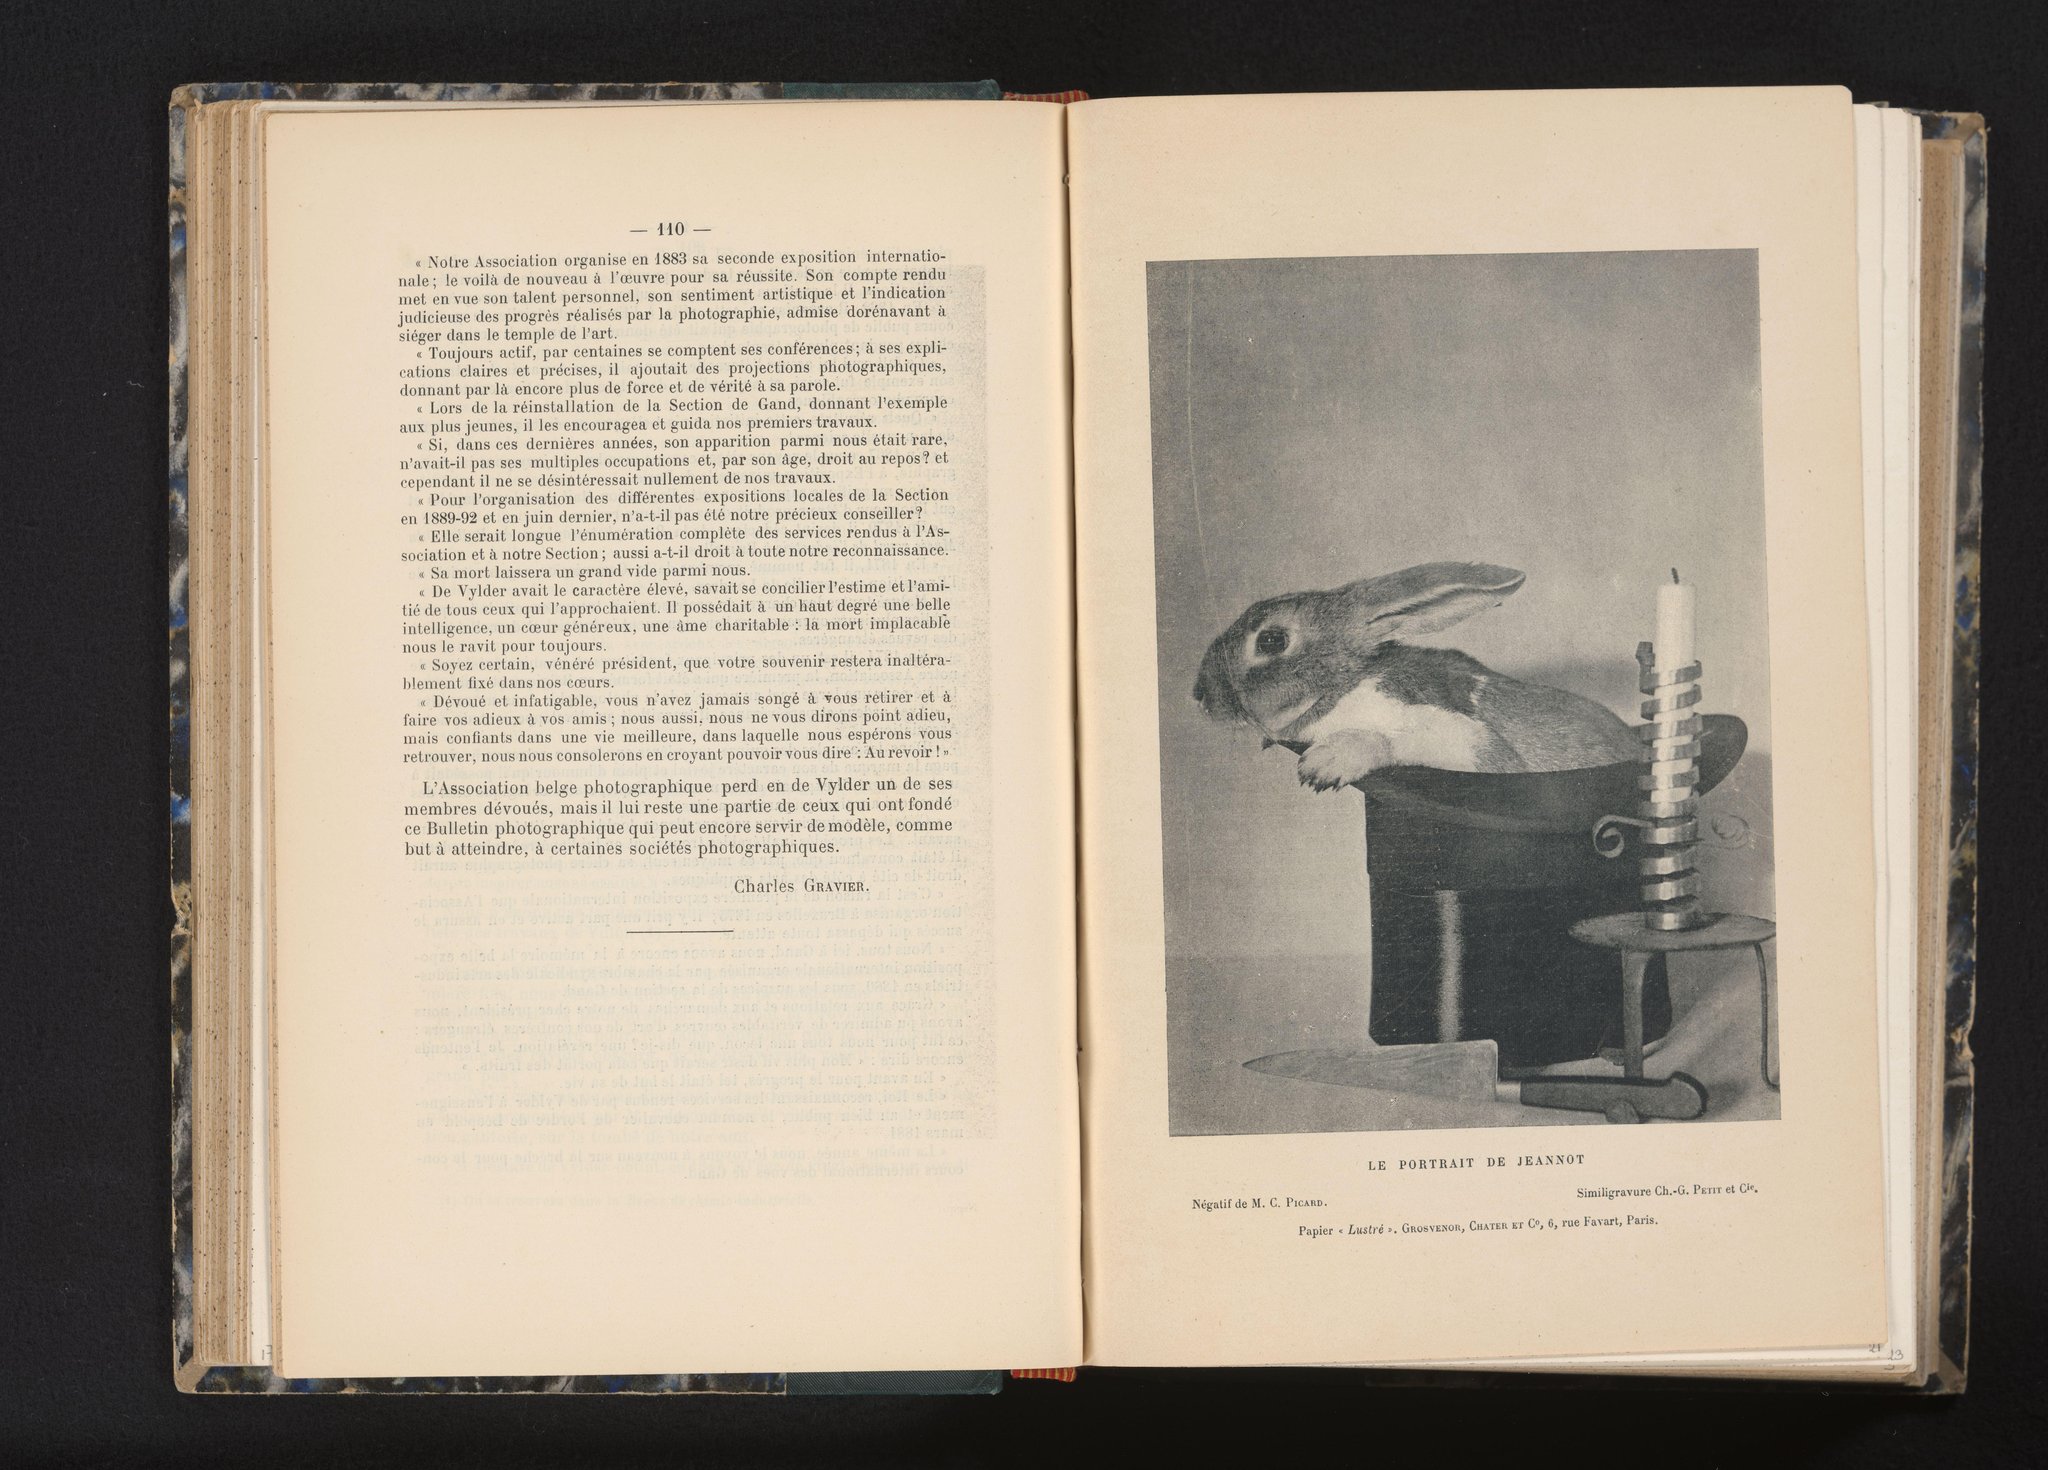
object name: page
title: Le Portrait de Jeannot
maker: c. picard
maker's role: fotograaf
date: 1891-1896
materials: paper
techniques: autotype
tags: rodents: rabbit, head-gear: top hat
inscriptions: inscription: ‘Papier < Lustré >. Grosvenor, Chater et Co, 6, rue Favart, Paris.’